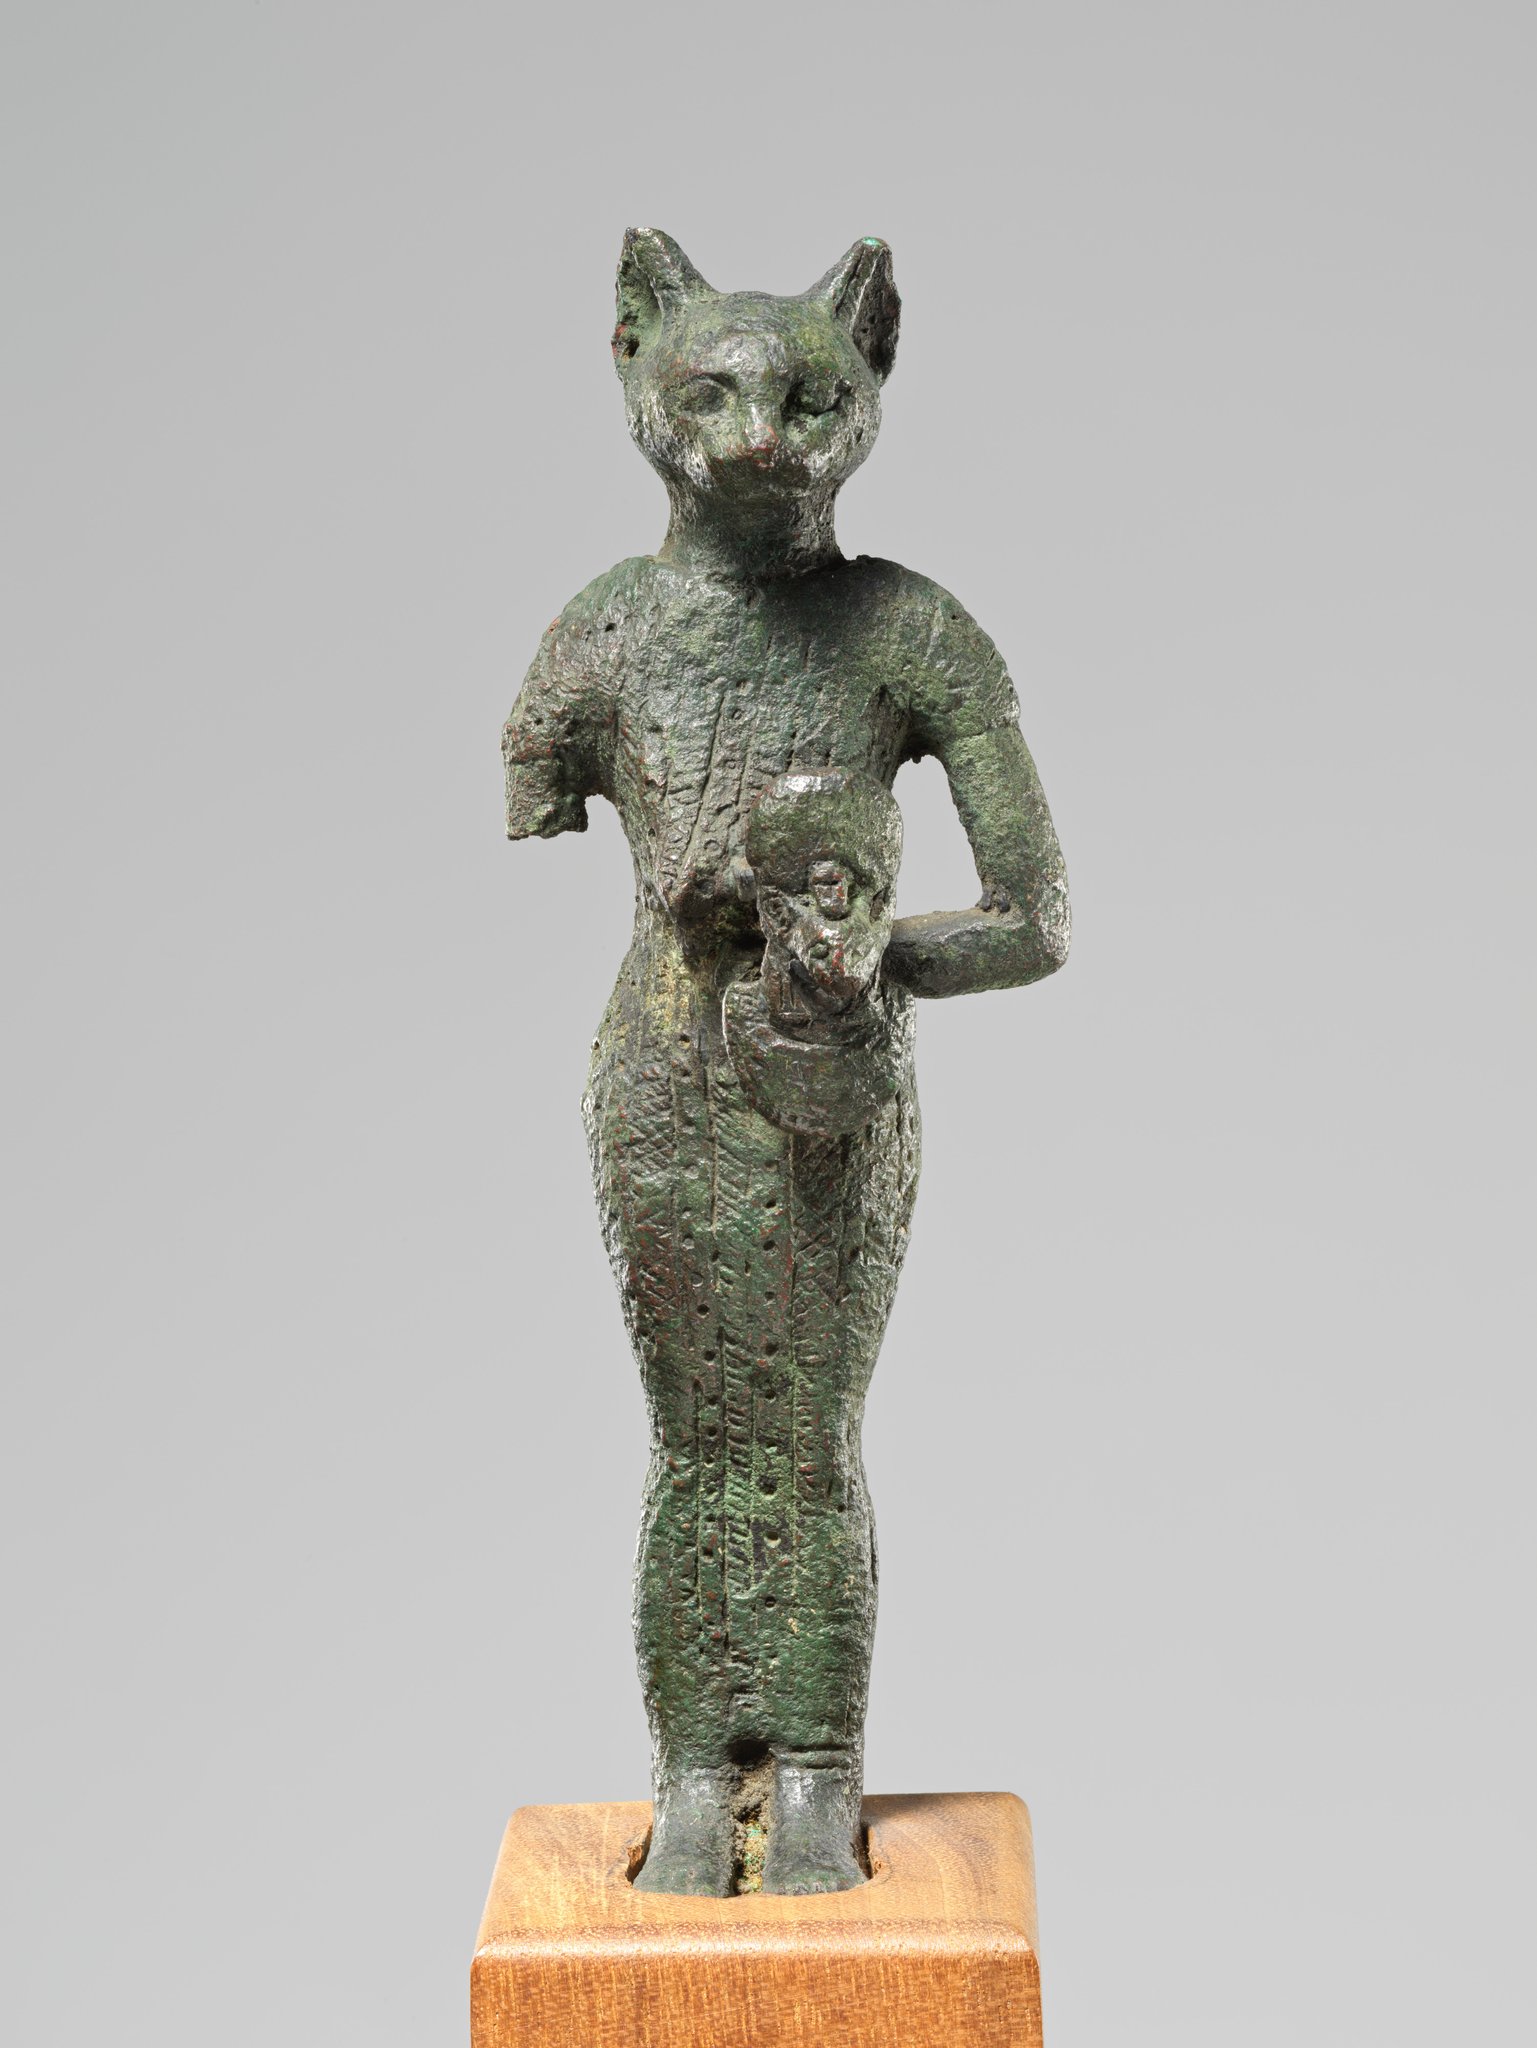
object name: bastet, standing, aegis, basket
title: Bastet holding aegis and basket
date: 664-630 BCE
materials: metal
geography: egypt